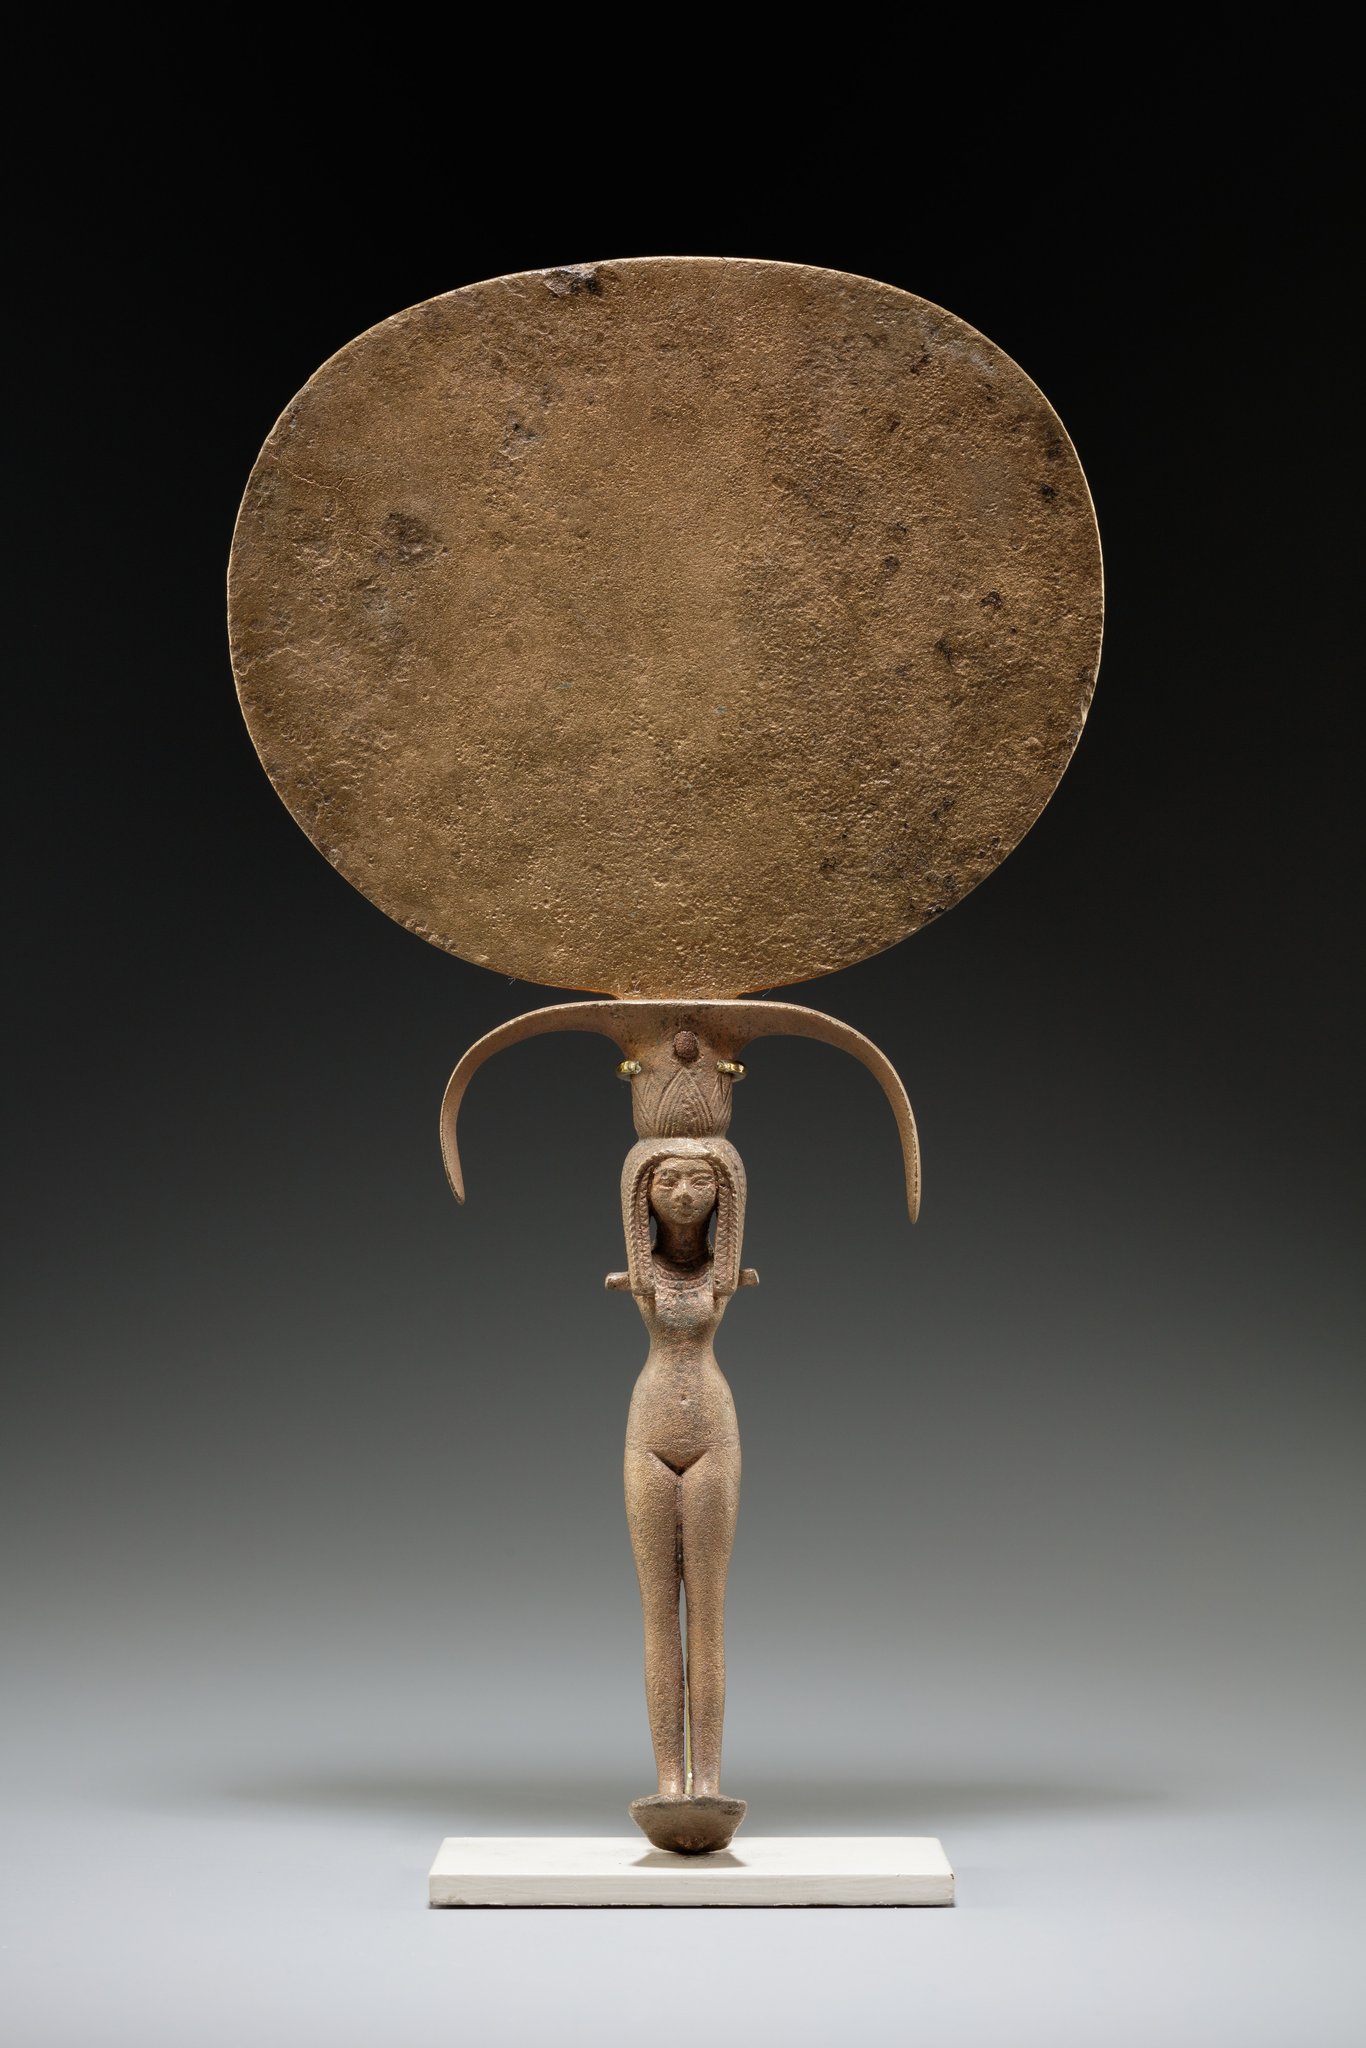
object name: mirror, papyrus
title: Mirror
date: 1550-1295 BCE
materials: bronze, copper alloy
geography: egypt